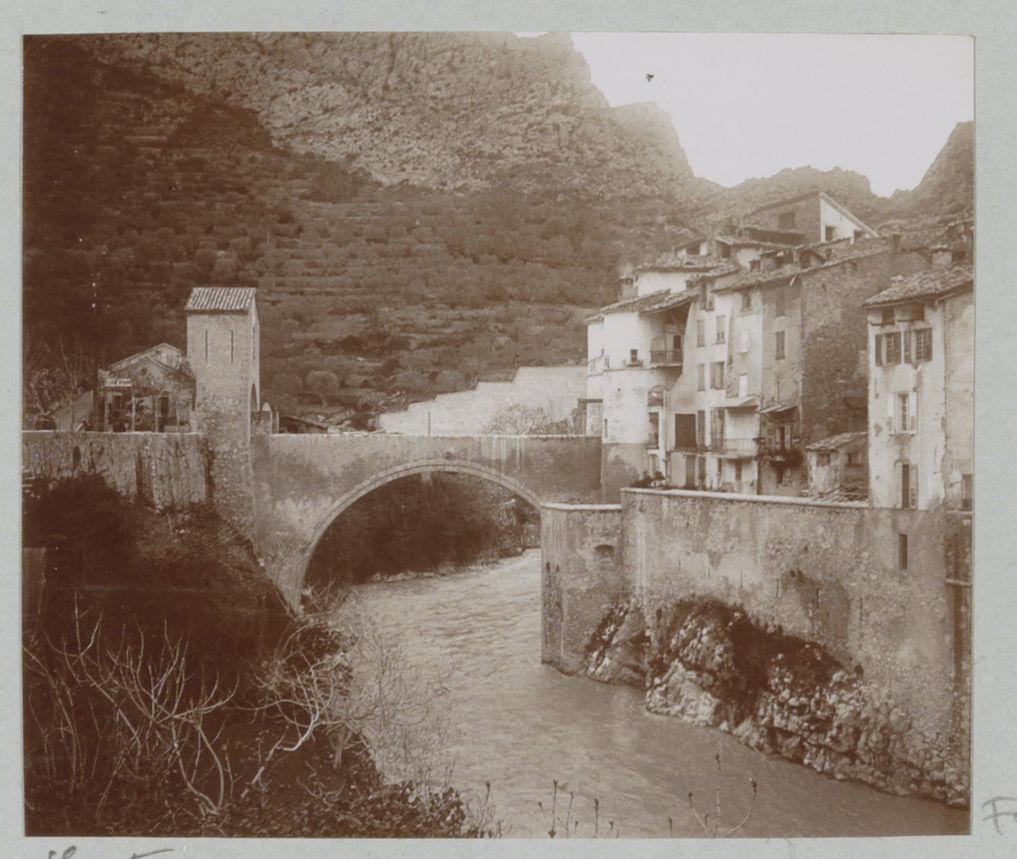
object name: photograph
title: Gezicht op een brug in het bergdorp Entrevaux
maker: delizy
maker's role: manufacturer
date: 1903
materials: paper, photographic support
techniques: gelatin silver print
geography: entrevaux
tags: prospect of village, silhouette of village, landscape with bridge, viaduct or aqueduct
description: Onderdeel van Fotoalbum van een Franse amateurfotograaf met opnames van uitstapjes in Frankrijk, Spanje, België, Luxemburg en Nederland, de eerste automobielen en autoraces.